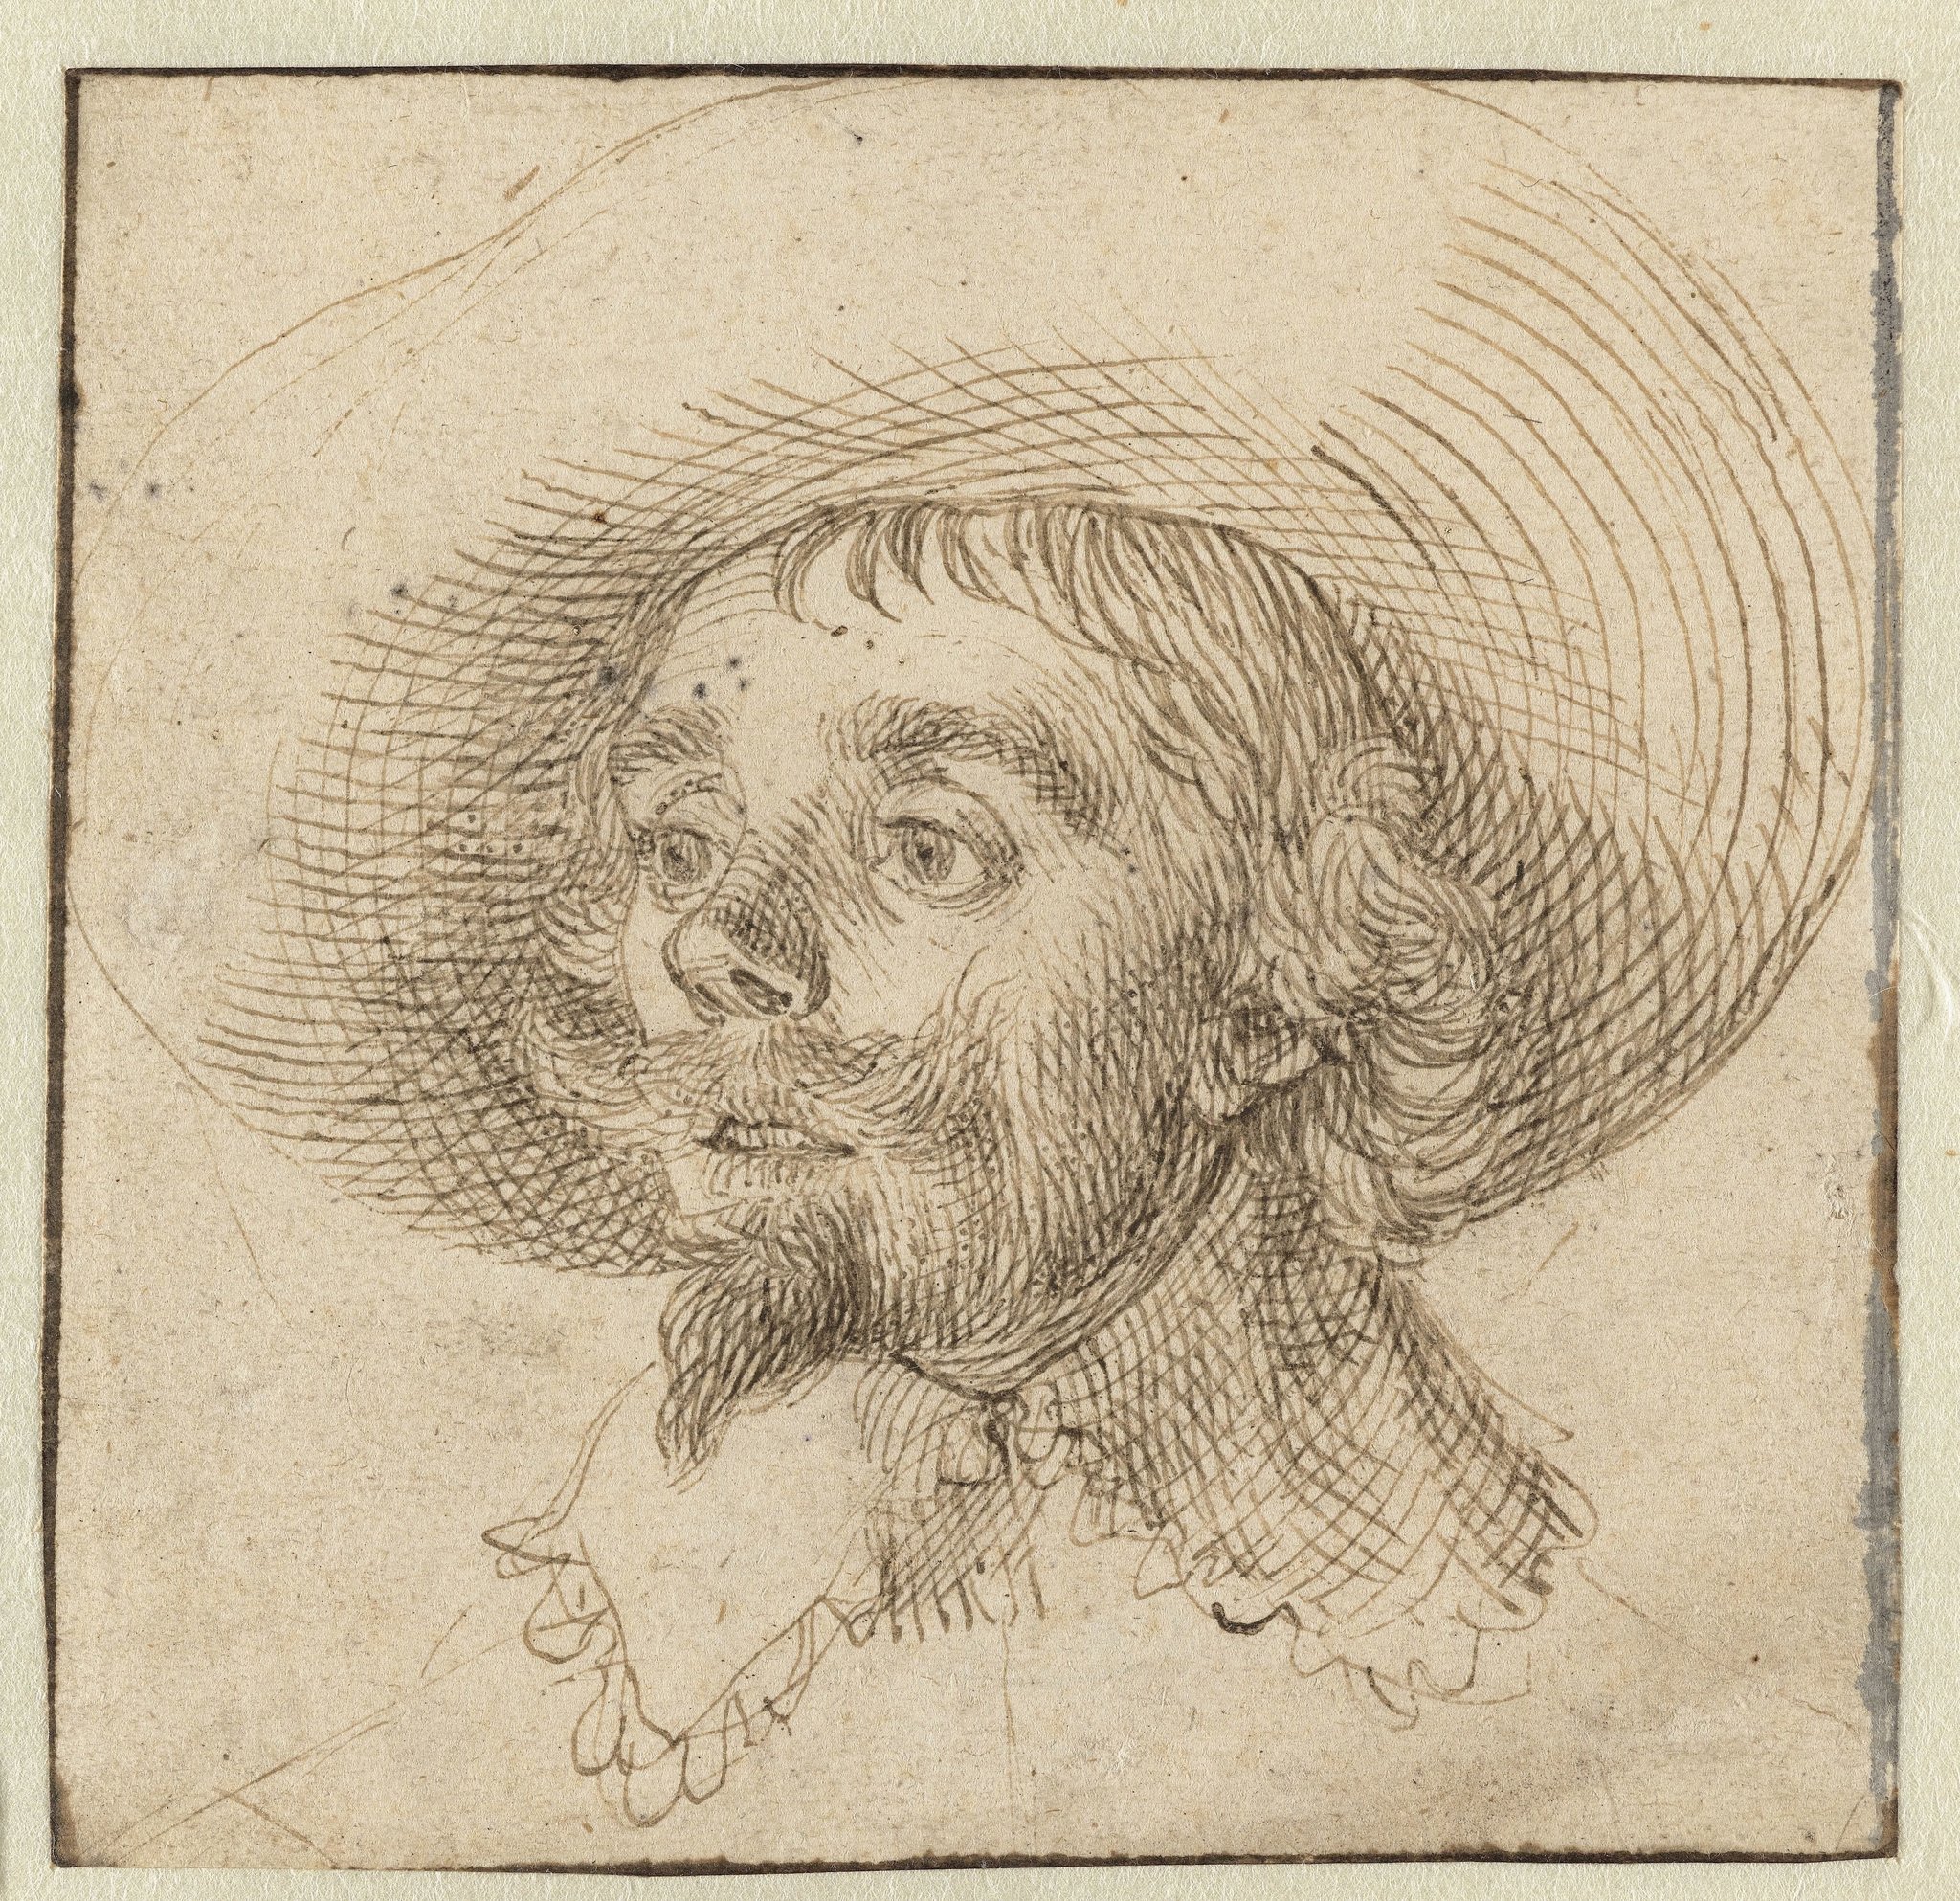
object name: design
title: Portret van Hendrick Cornelisz Vroom (?)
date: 1594-1657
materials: ink, paper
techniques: pen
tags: painter, draughtsman, hendrick cornelisz vroom, historical persons, portrait, self-portrait of artist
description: Portret van een jongeman met een breedgerande hoed, een puntbaard en een snor. Ontwerp voor een prent.